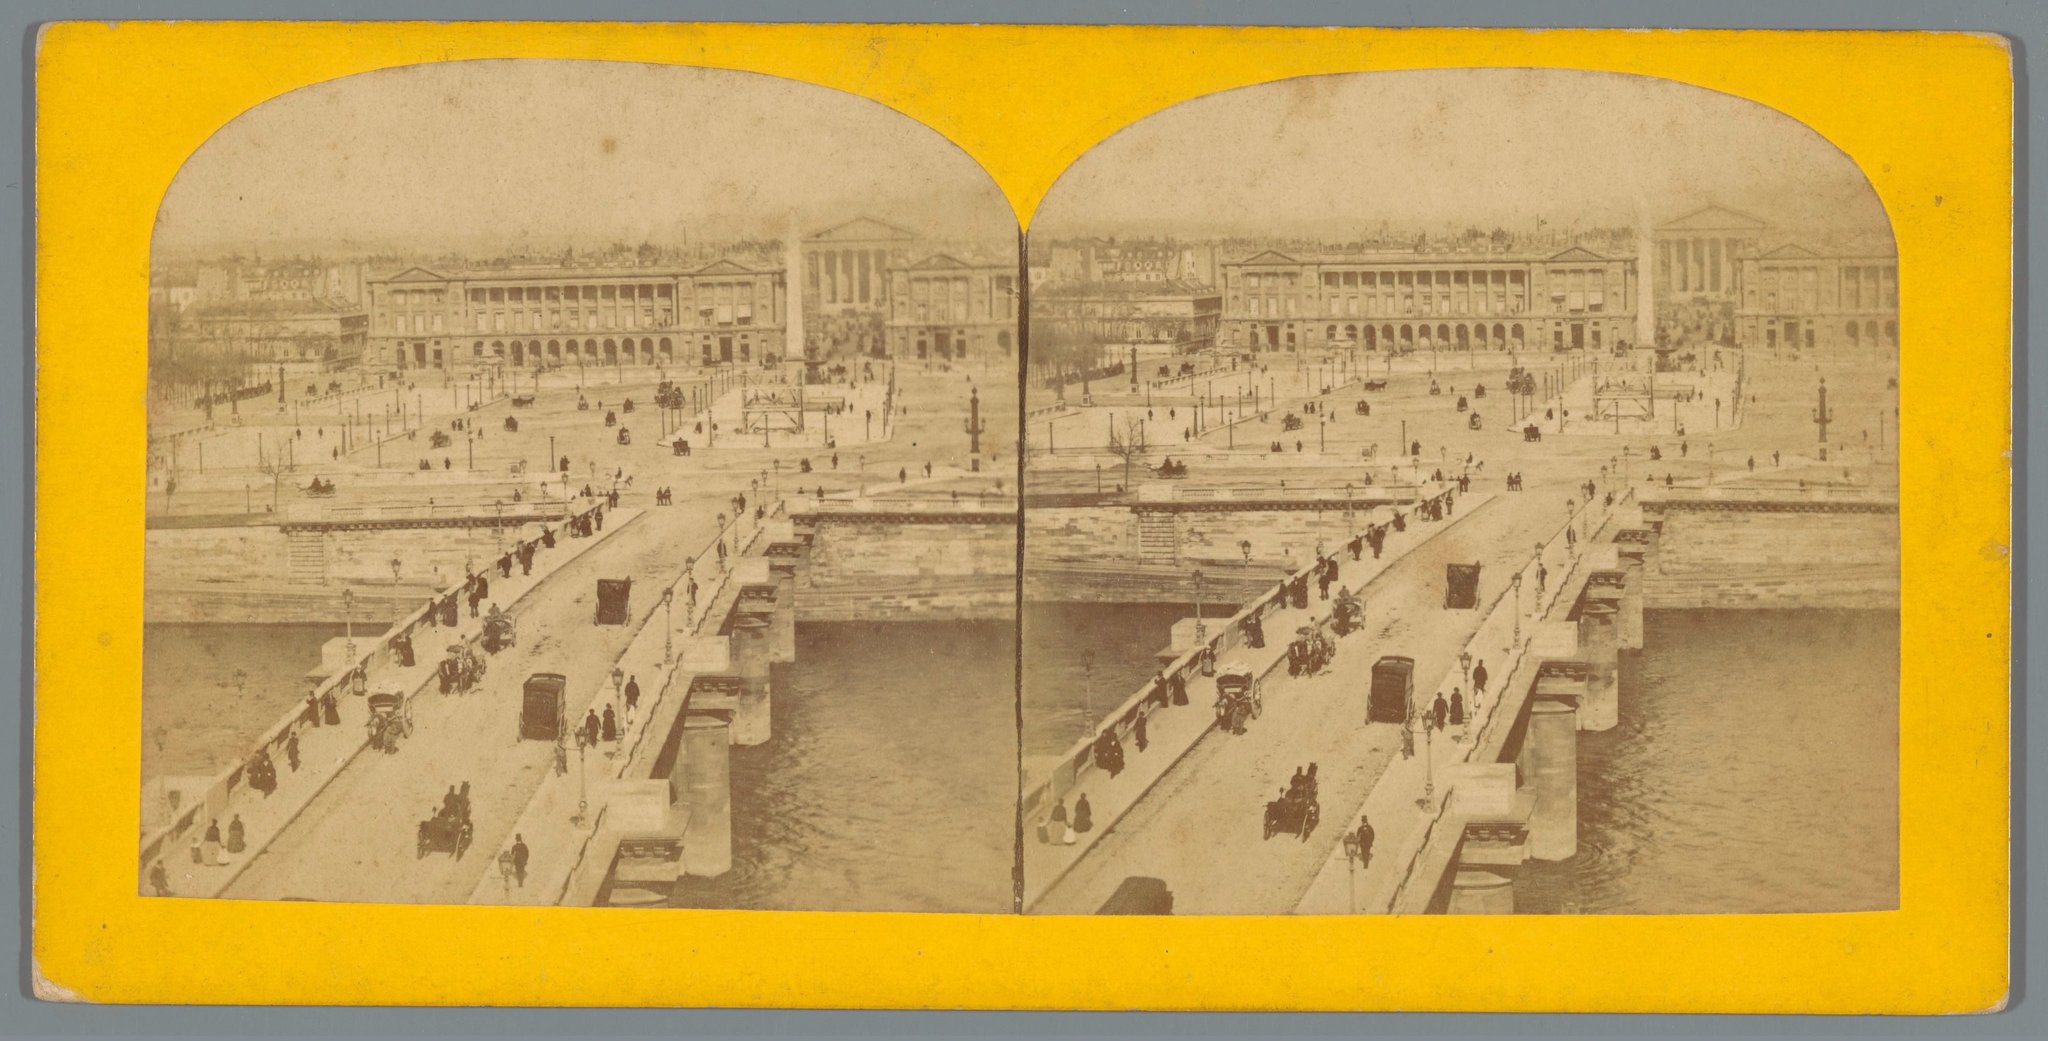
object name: stereograph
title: Gezicht op de Pont de la Concorde, Place de la Concorde en La Madeleine in Parijs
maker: Anonymous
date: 1850-1880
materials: cardboard, photographic support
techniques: albumen print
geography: paris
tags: square, place, circus, etc., bridge in city across river, canal, etc.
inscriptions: inscription: ‘Pont de la Concorde’